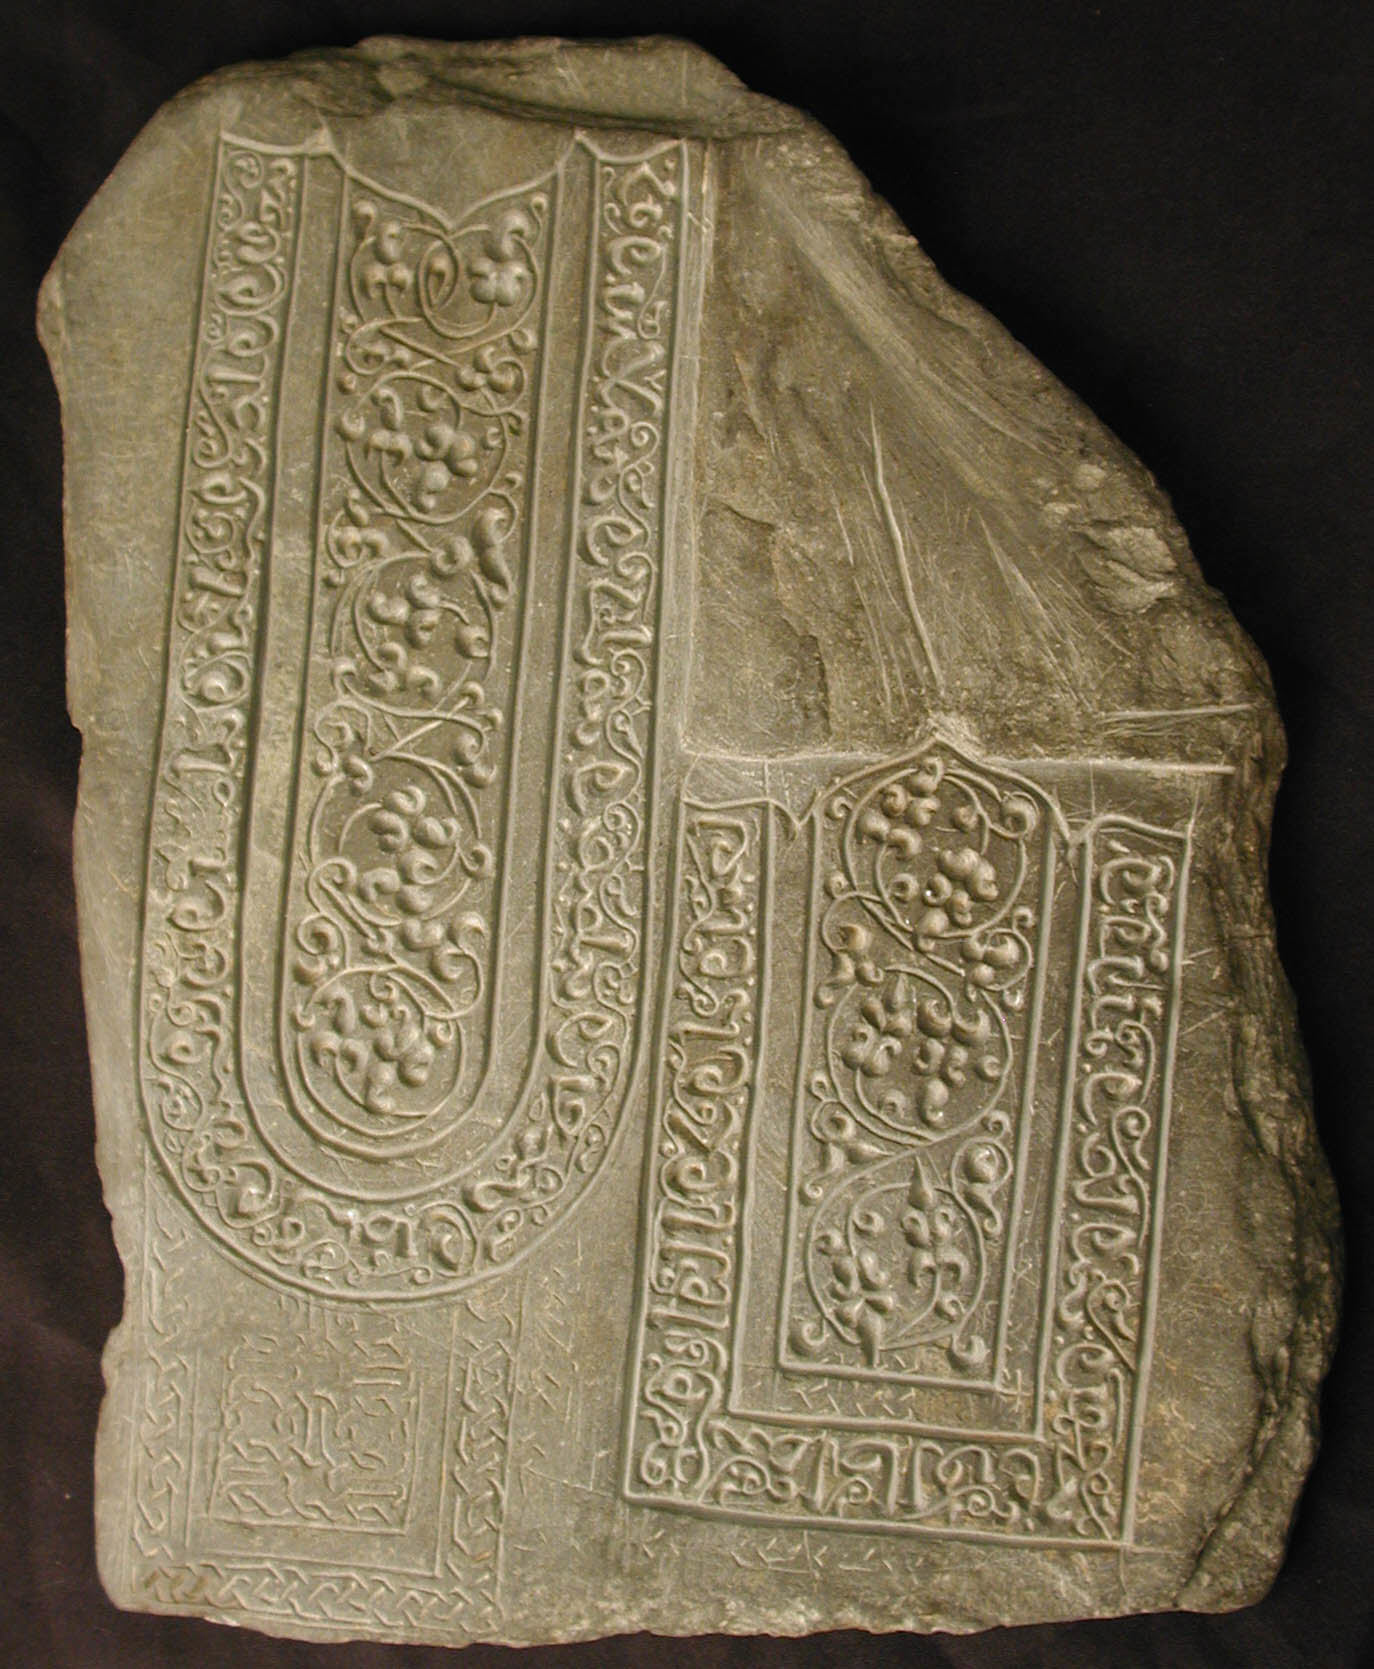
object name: pattern block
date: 1101-1200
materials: stone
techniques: carving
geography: iran